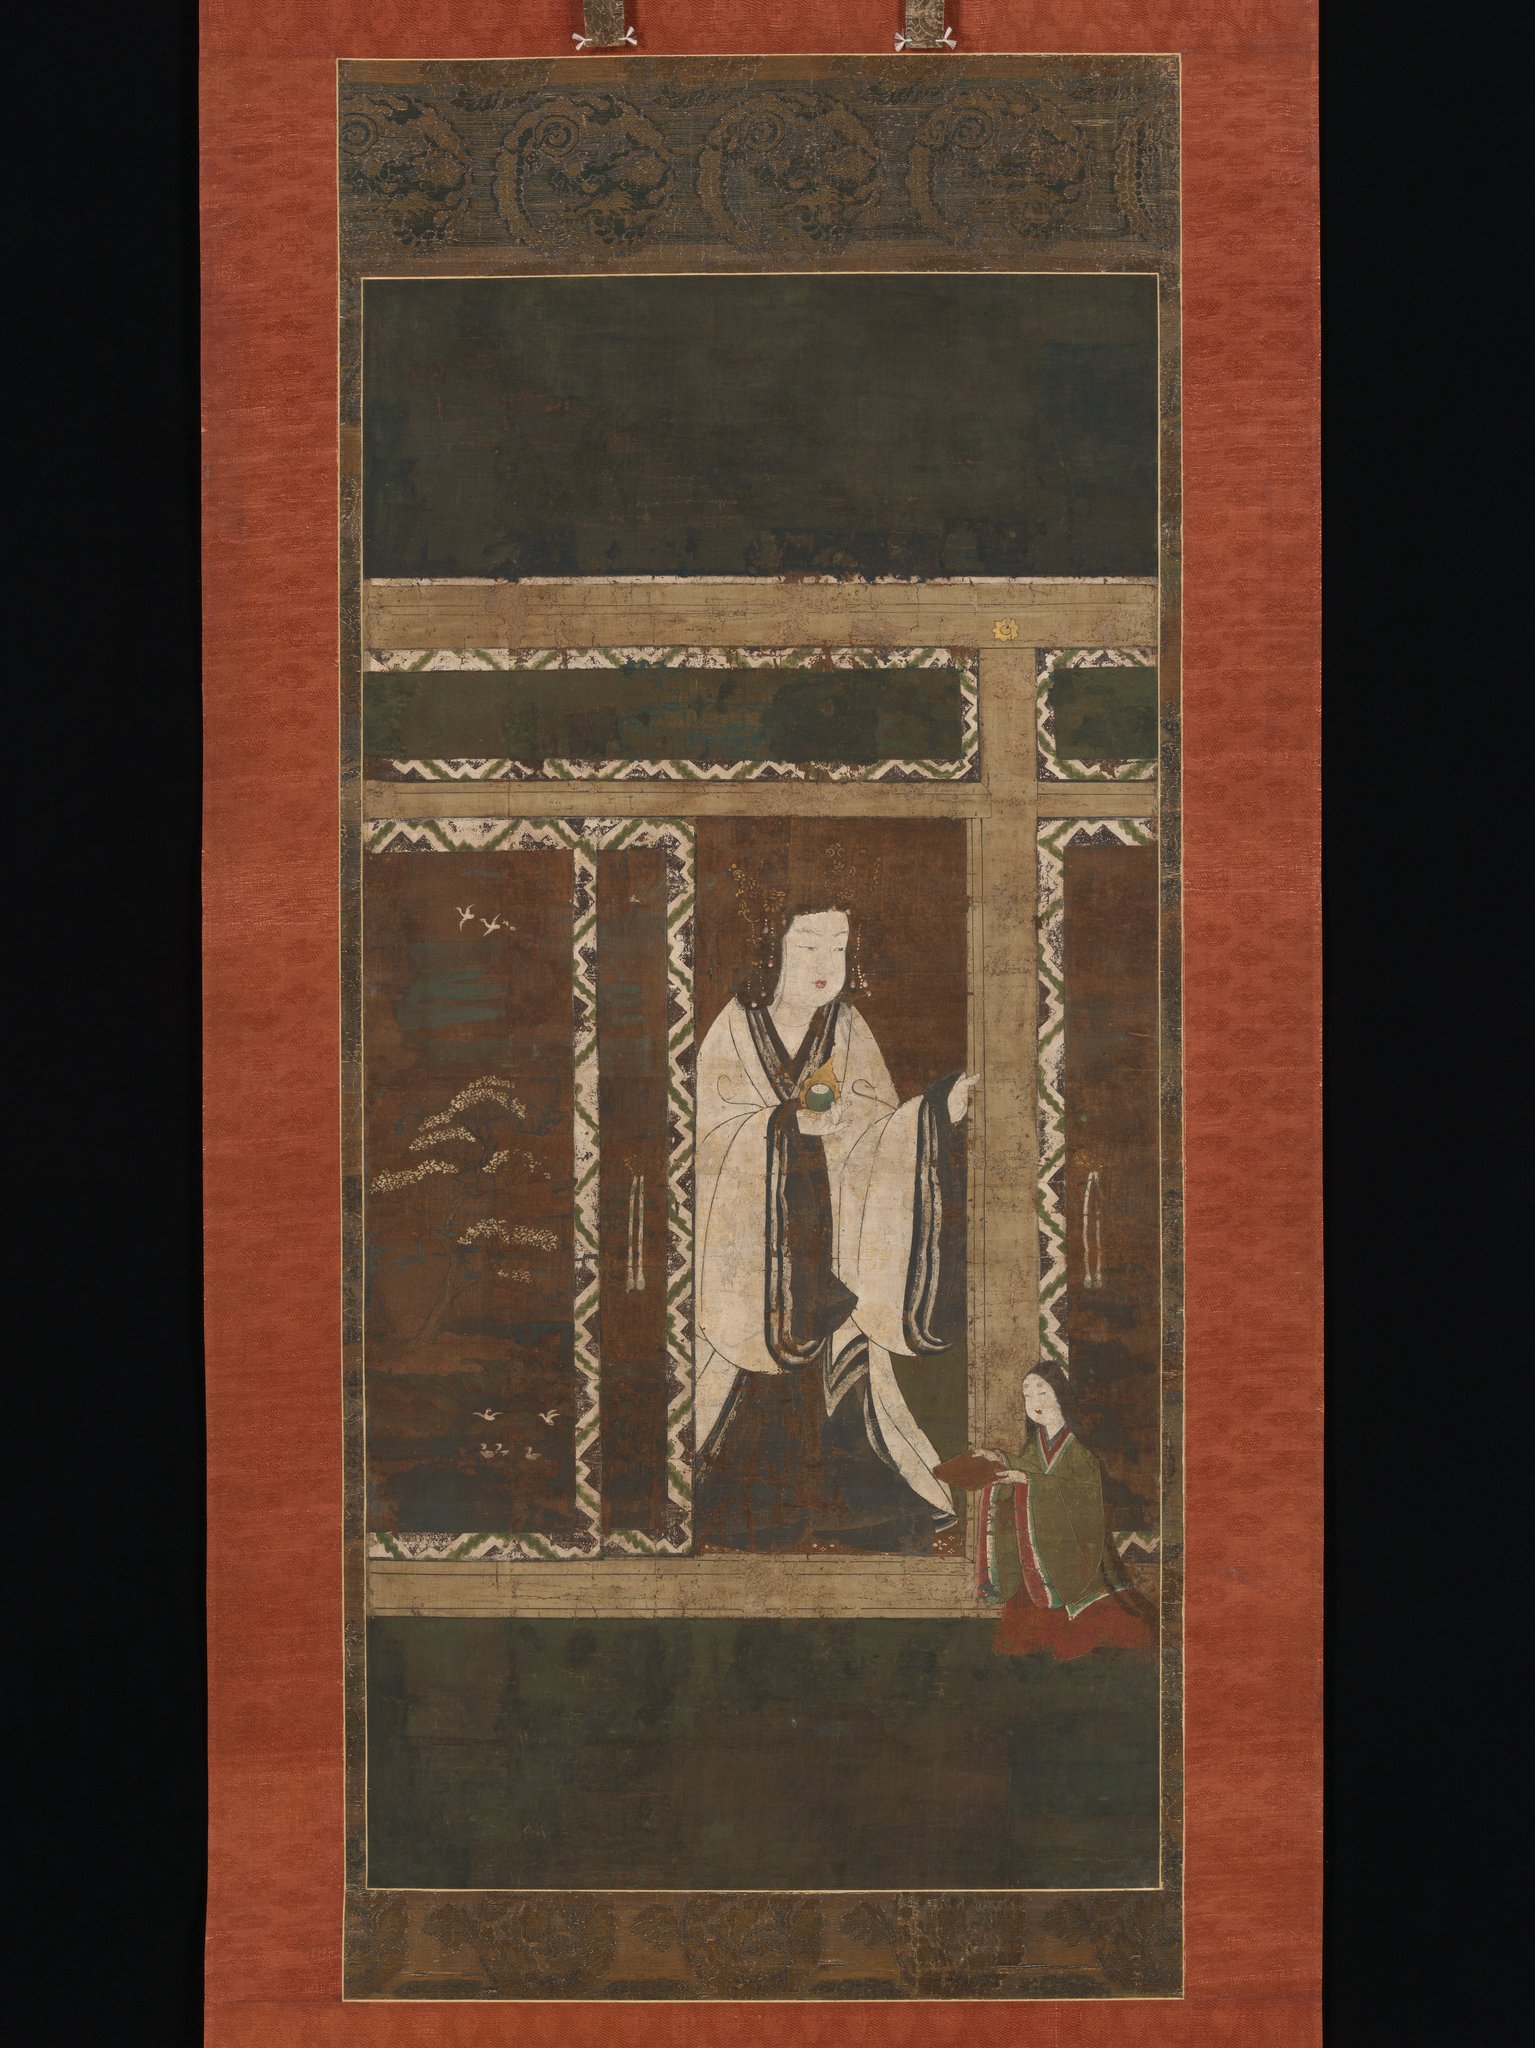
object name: hanging scroll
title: Seiryū Gongen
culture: japanese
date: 1334-1366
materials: ink, silk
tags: women,deities